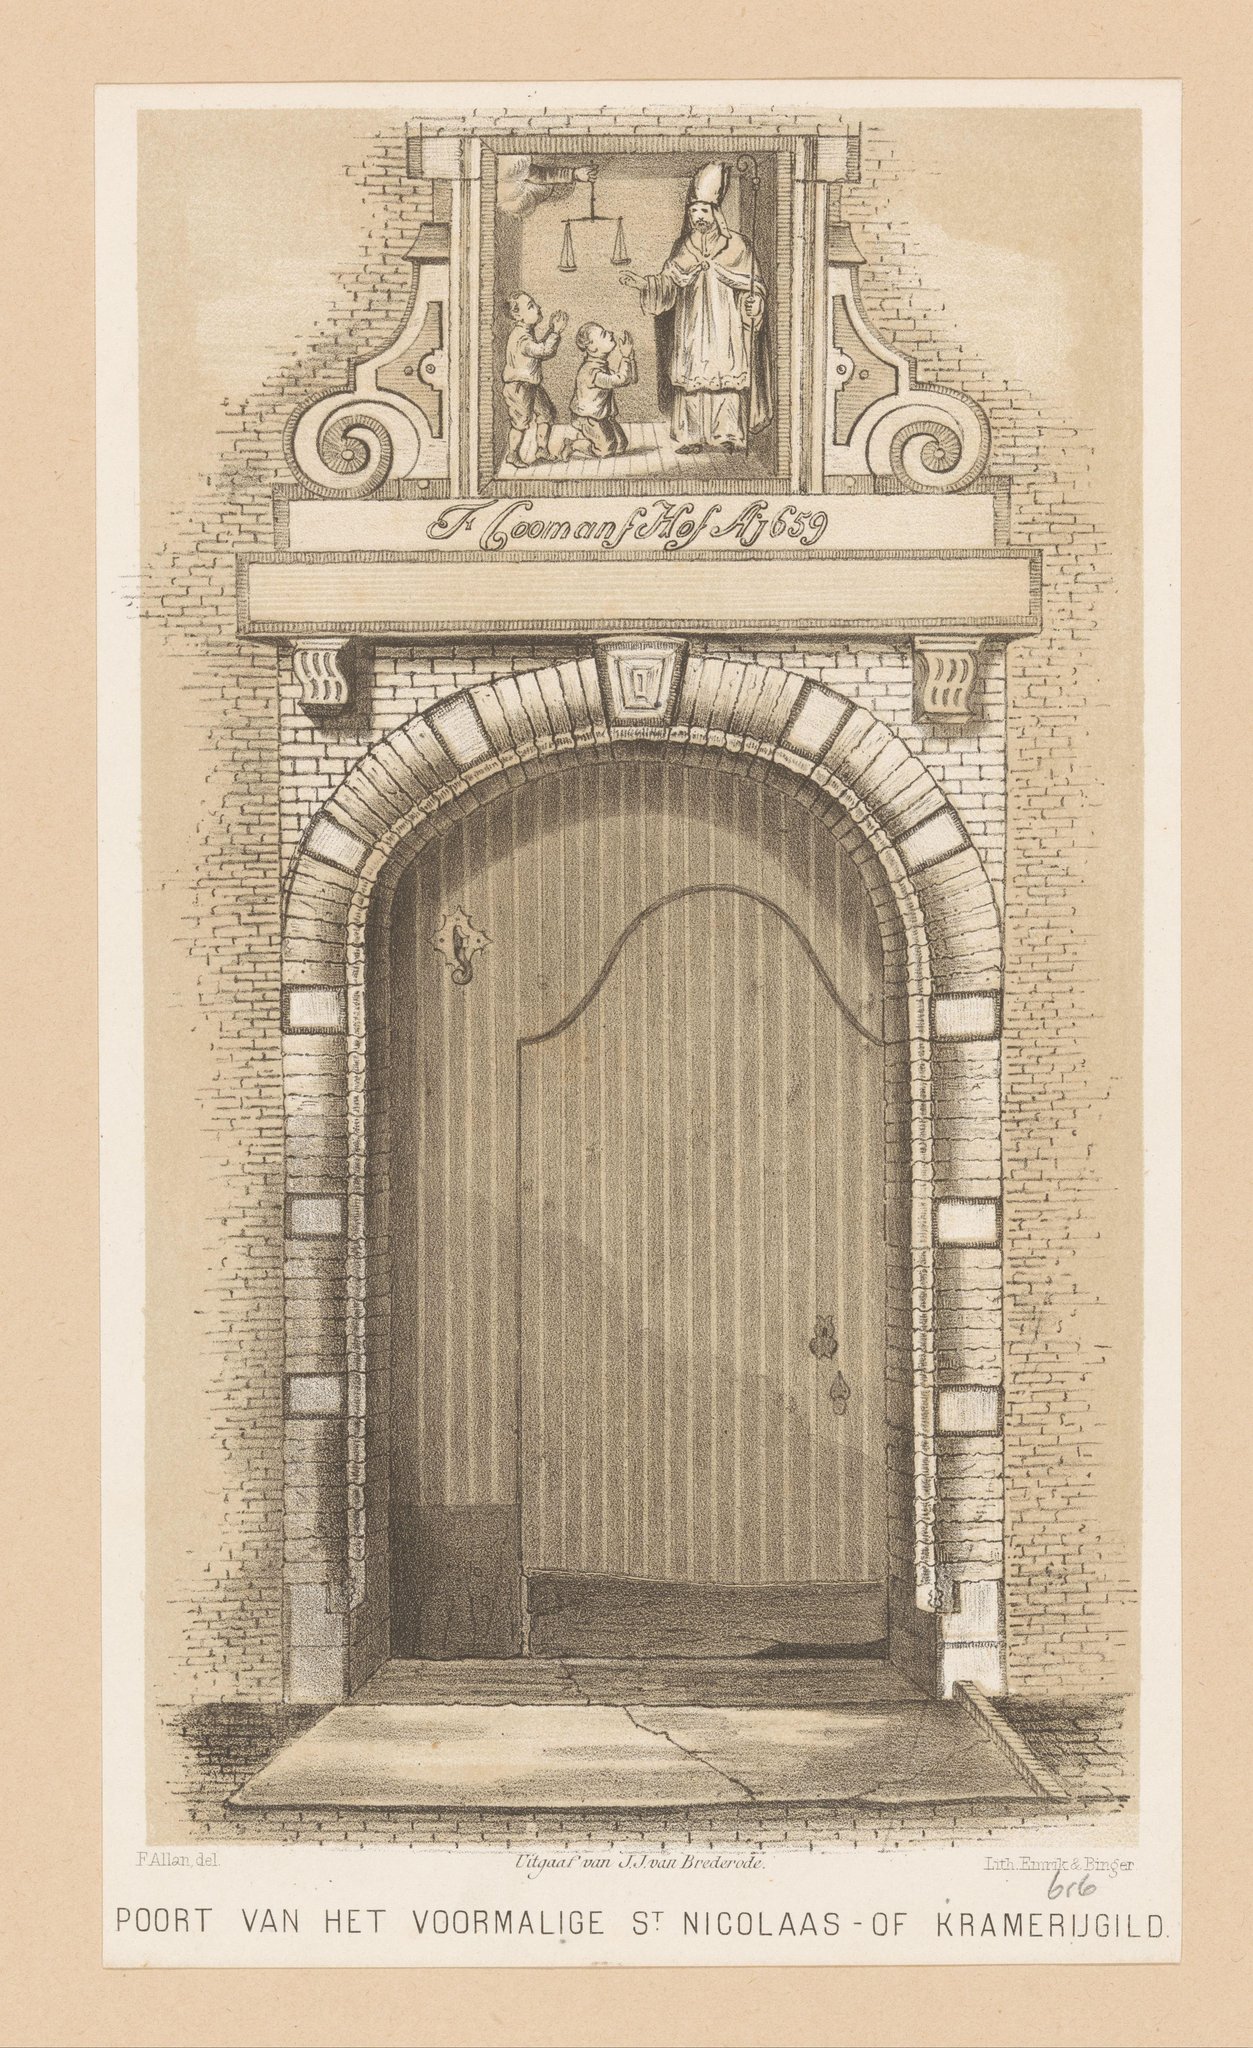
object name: print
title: Poort van het voormalige St. Nicolaas- of Kramerijgild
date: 1874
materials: paper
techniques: tone lithography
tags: monumental door, porch, 'aediculum', merchant guild, haarlem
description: Prent uit: Allan, Francis. Geschiedenis en beschrijving van Haarlem (...). 4 dln. 1874-1888, dl. 1 (1874), p. 388-389.